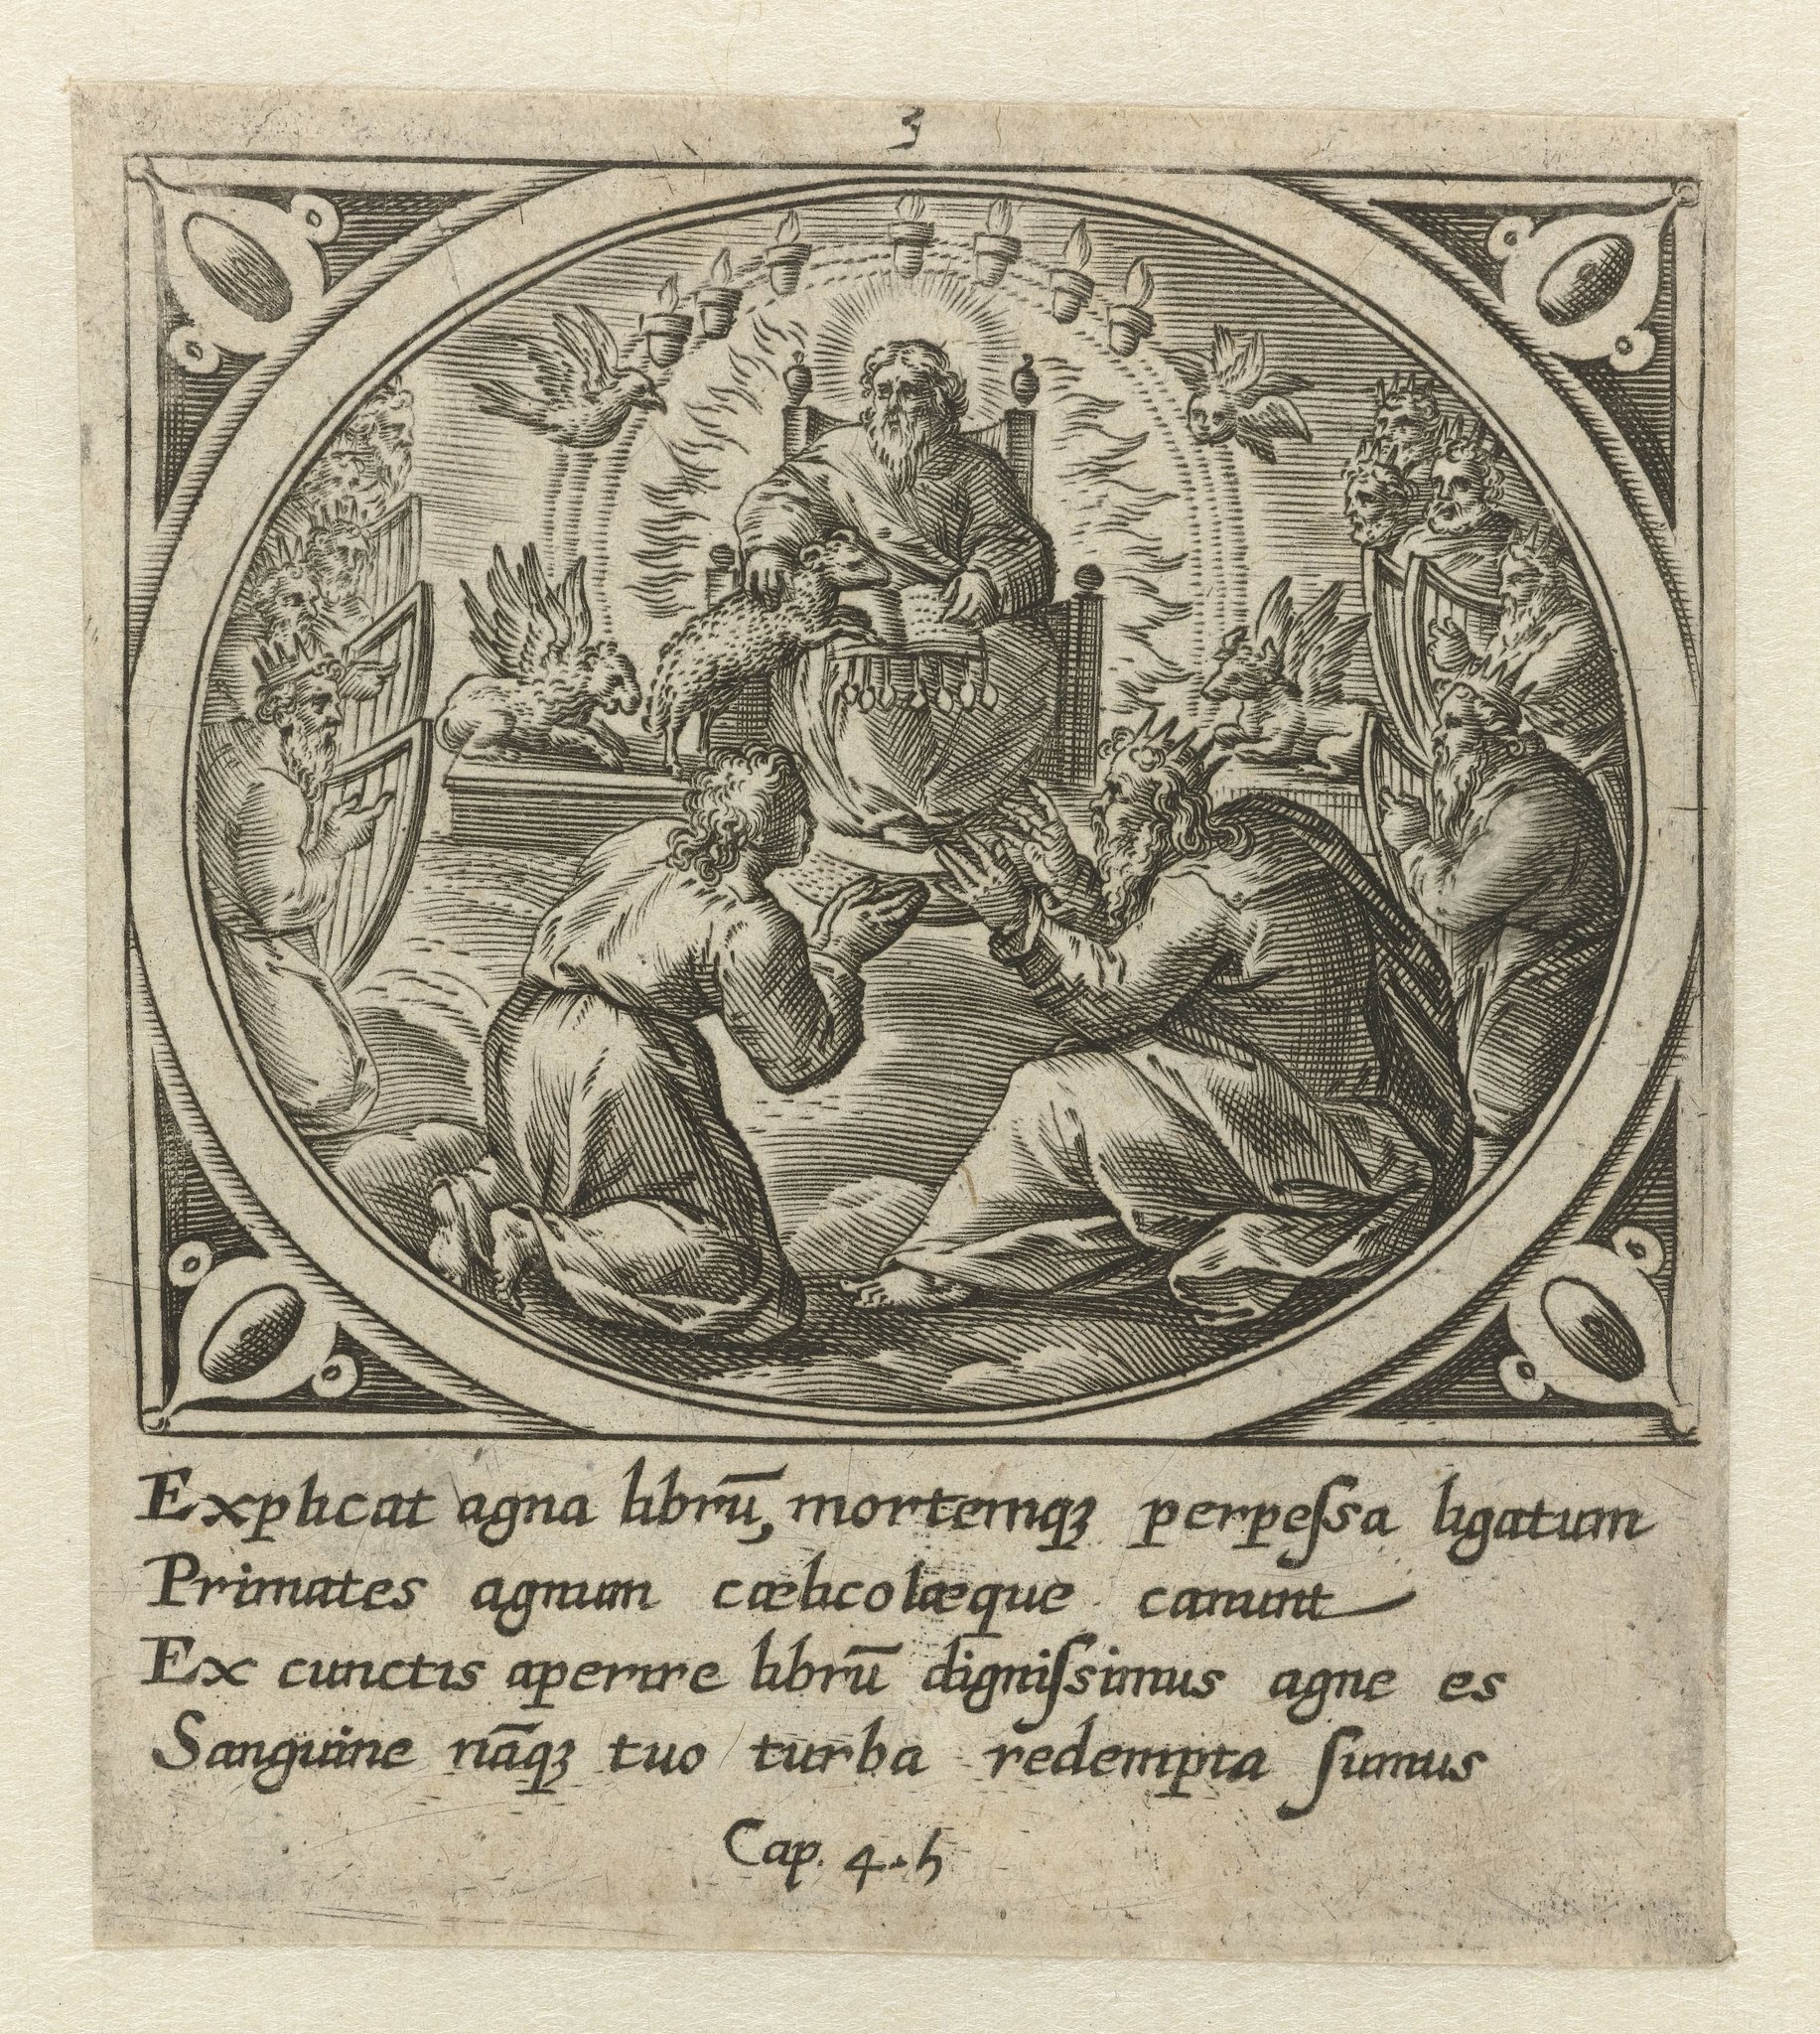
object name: print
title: Icones Revelationum S Johs Evangeliste in Pathmo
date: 1585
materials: paper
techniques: engraving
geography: antwerp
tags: the throne of god ~ revelation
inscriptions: collector's mark: Lugt 2760, collector's mark: Lugt 2228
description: God de Vader, zittend op zijn troon met boek op zijn schoot en het Lam. De troon is omgeven door de zeven fakkels, de vier Apocalyptische dieren en de 24 oudsten, de harp bespelend. In de marge een vierregelig onderschrift in het Latijn. Derde prent uit een serie van vierentwintig met de openbaring van Johannes op Patmos.